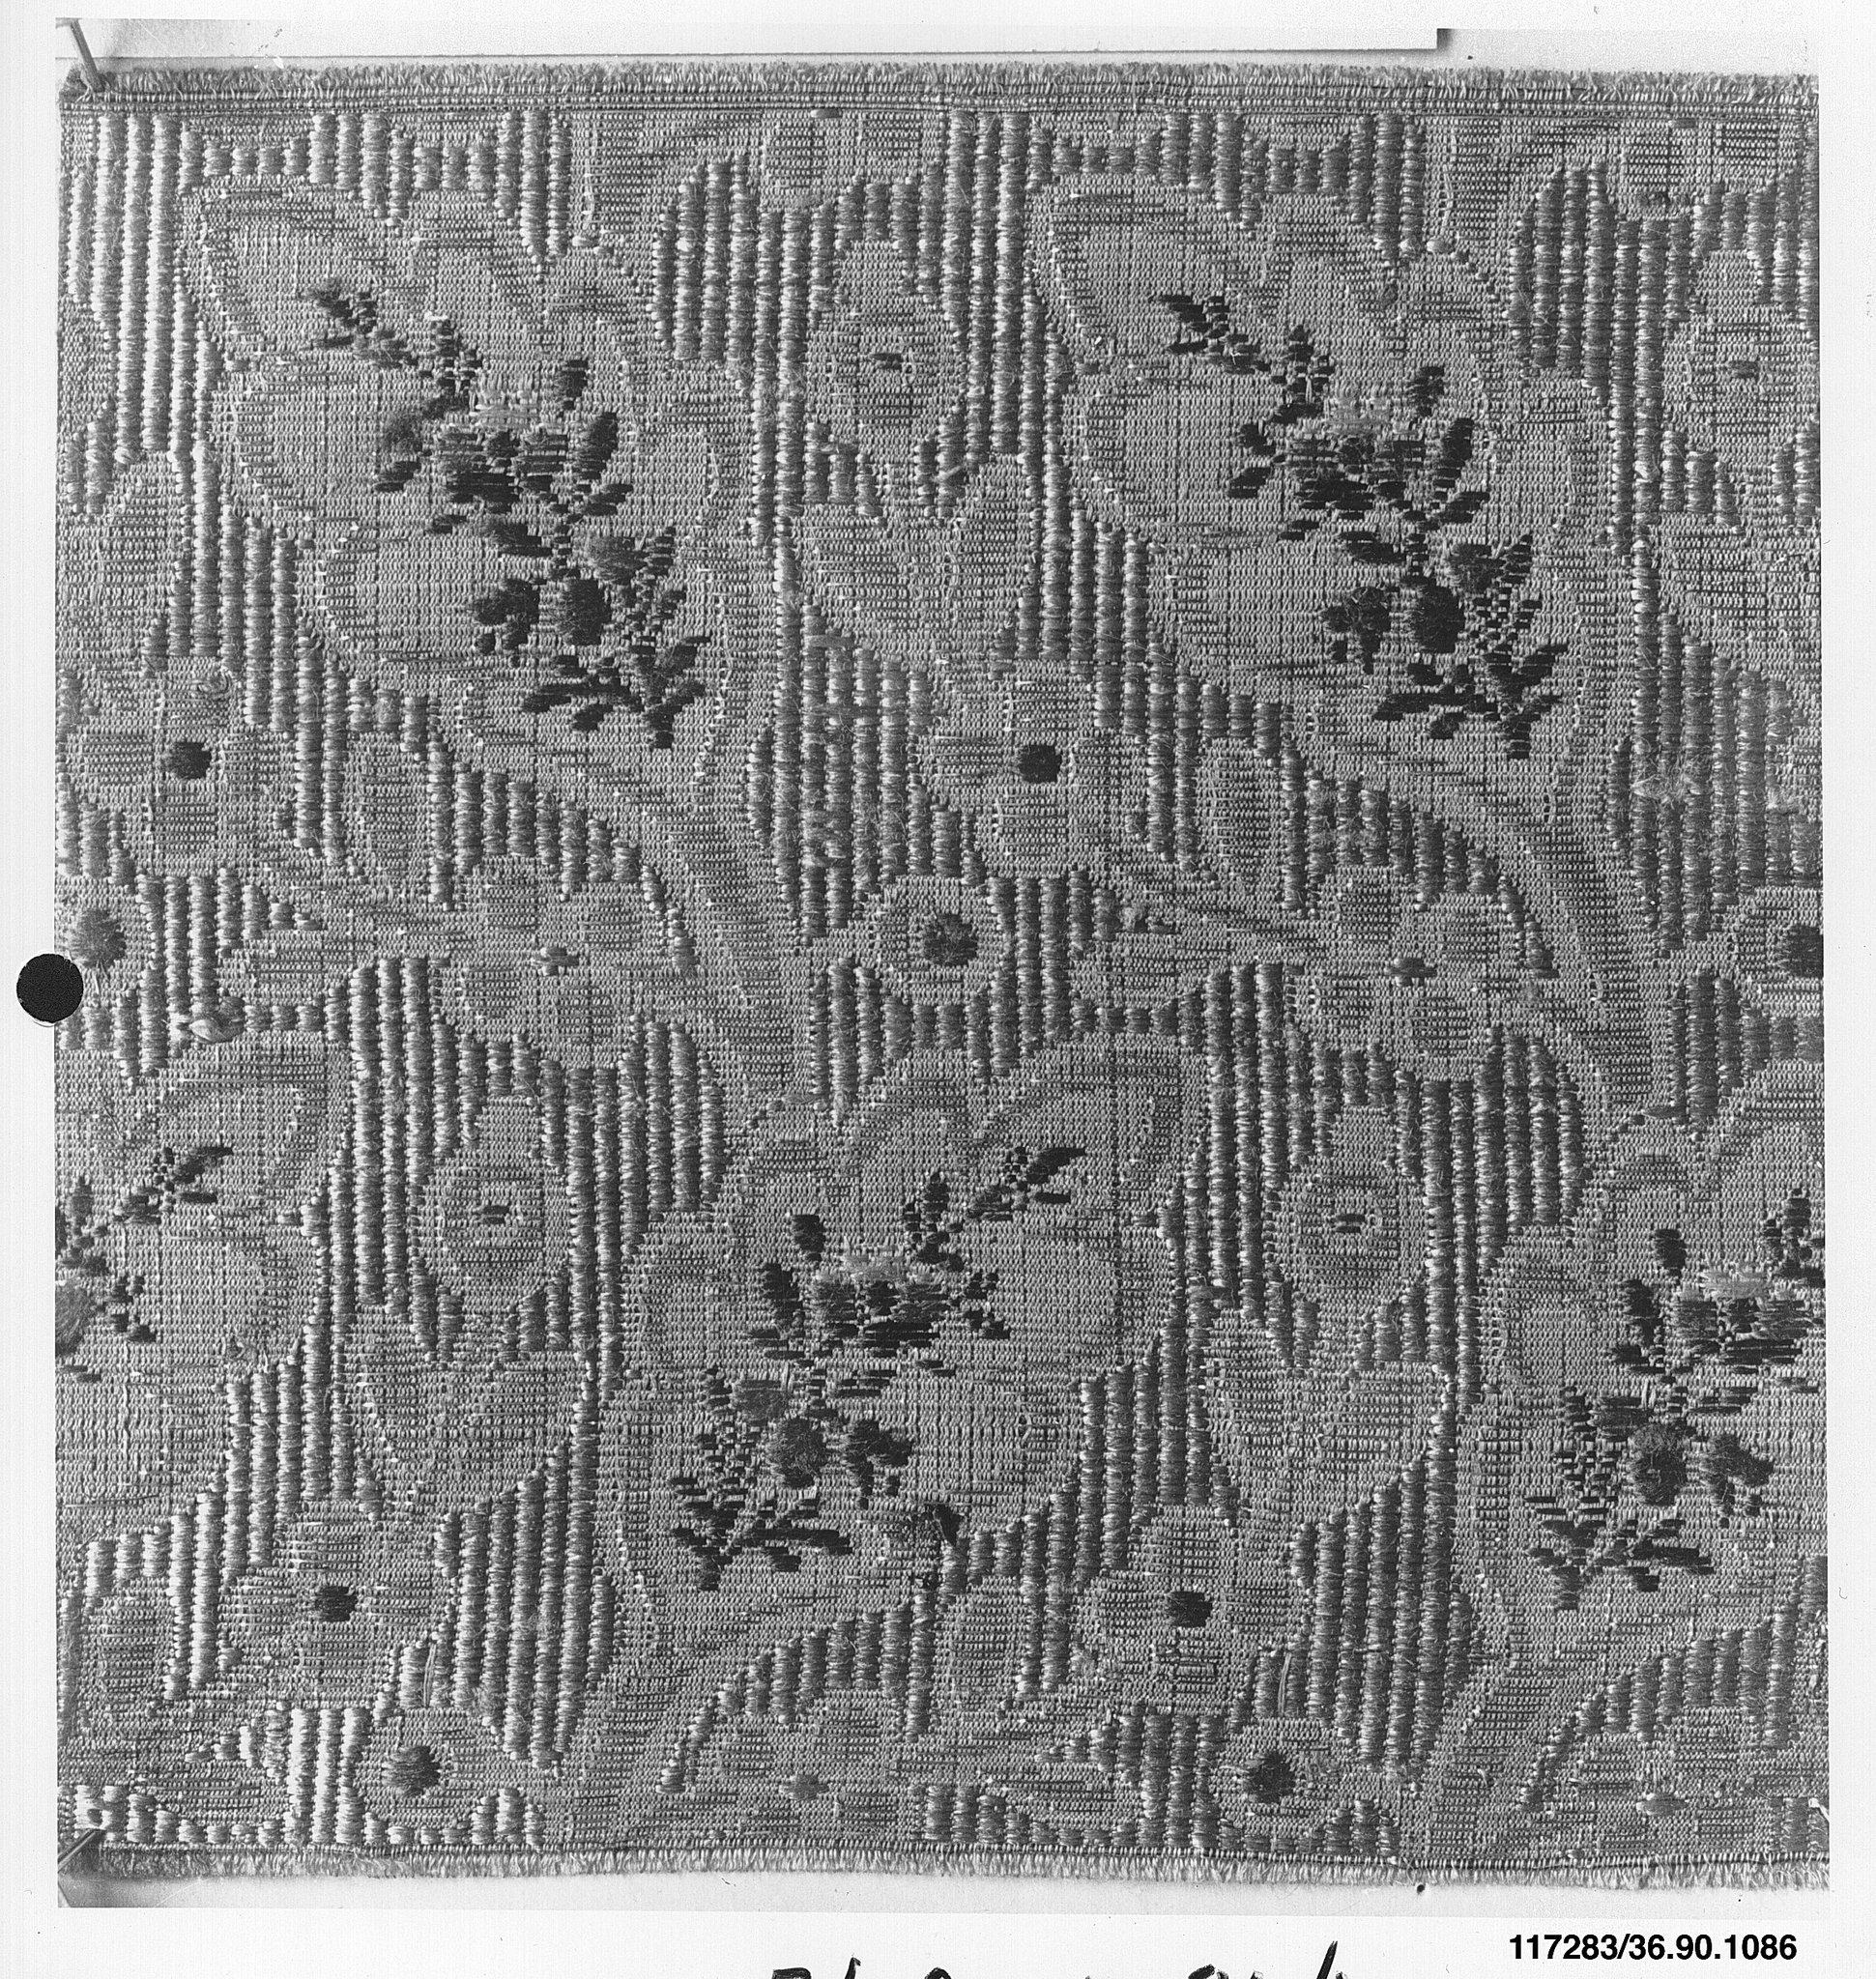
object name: piece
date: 1701-1900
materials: metal thread, silk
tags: flowers,leaves